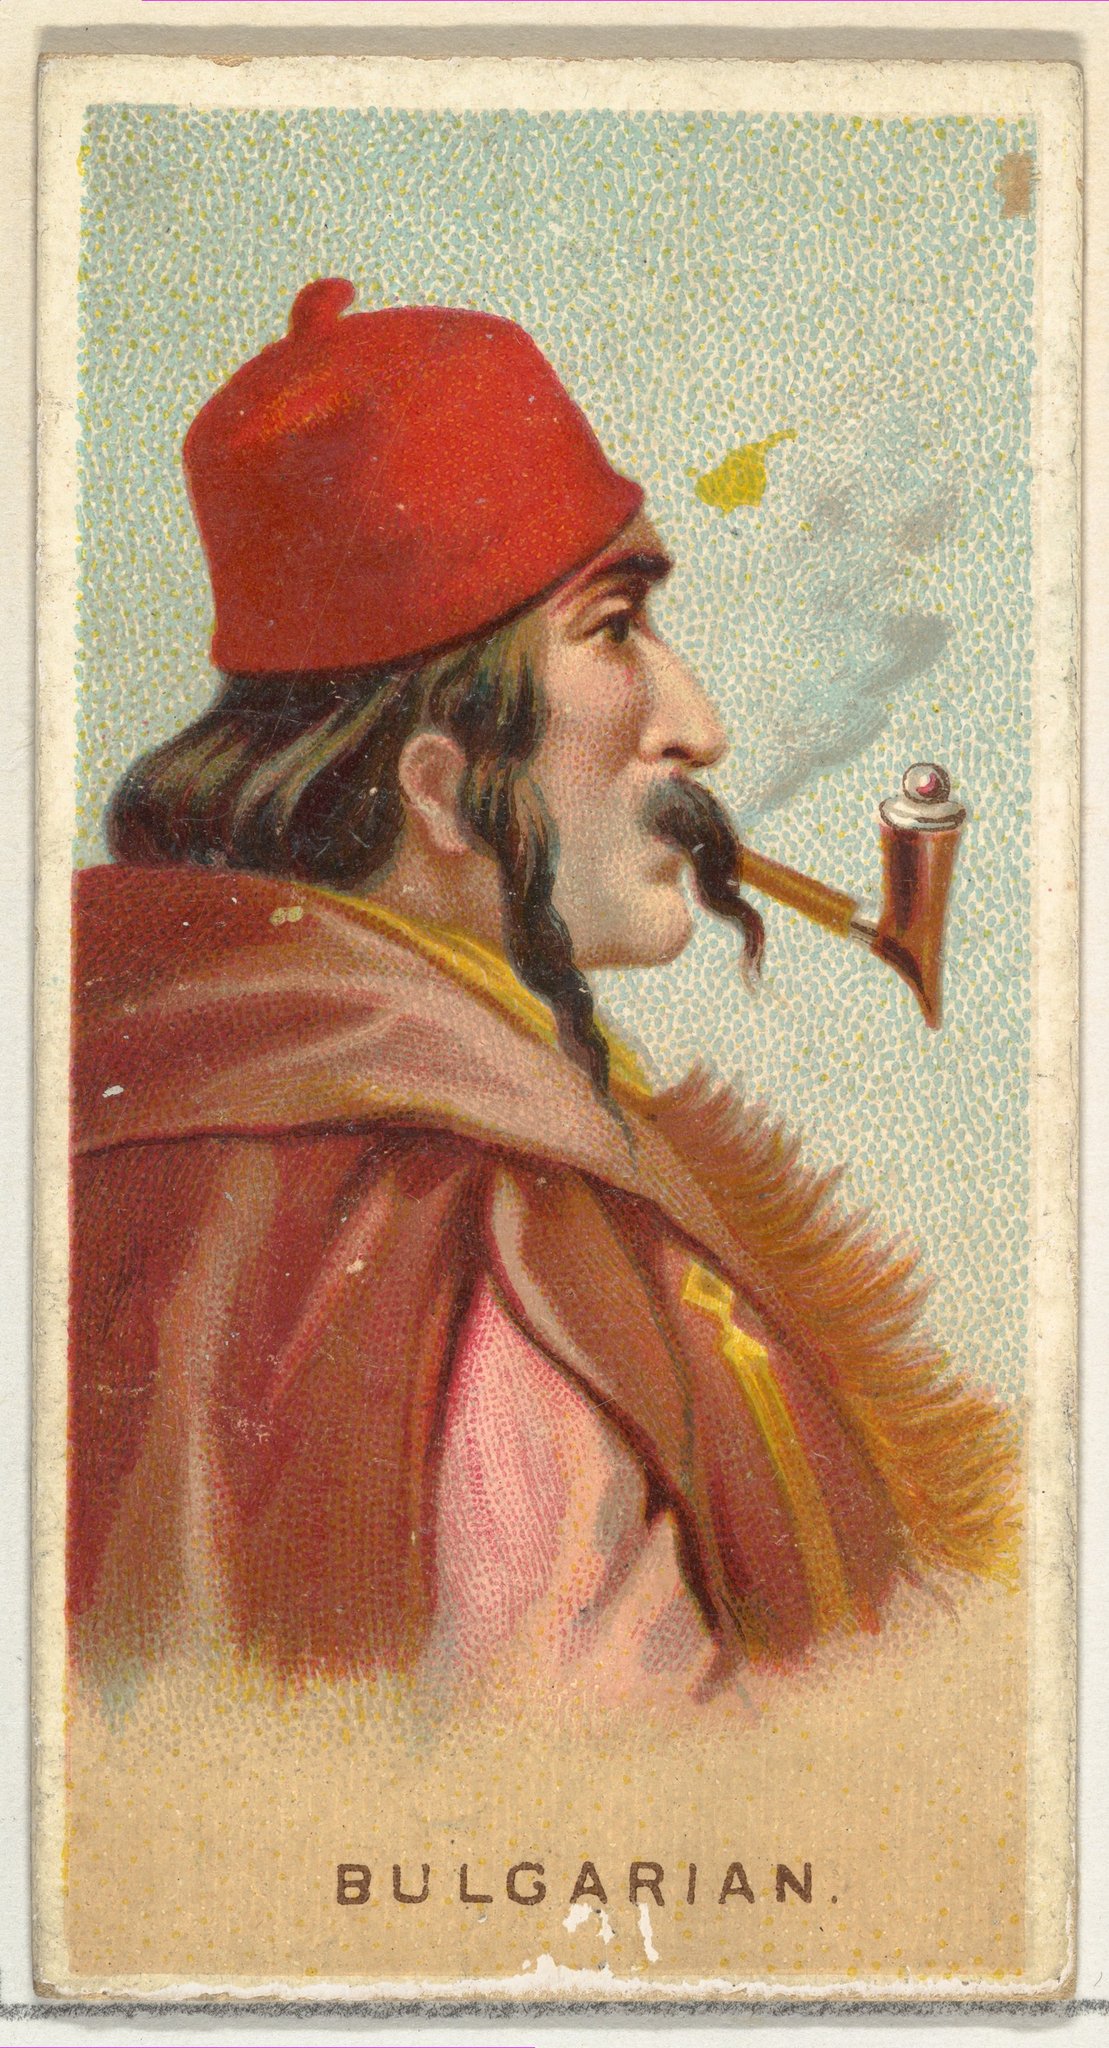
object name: print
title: Bulgarian, from World's Smokers series (N33) for Allen & Ginter Cigarettes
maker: allen & ginter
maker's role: publisher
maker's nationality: american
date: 1888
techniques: color lithograph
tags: men,profiles,smoking